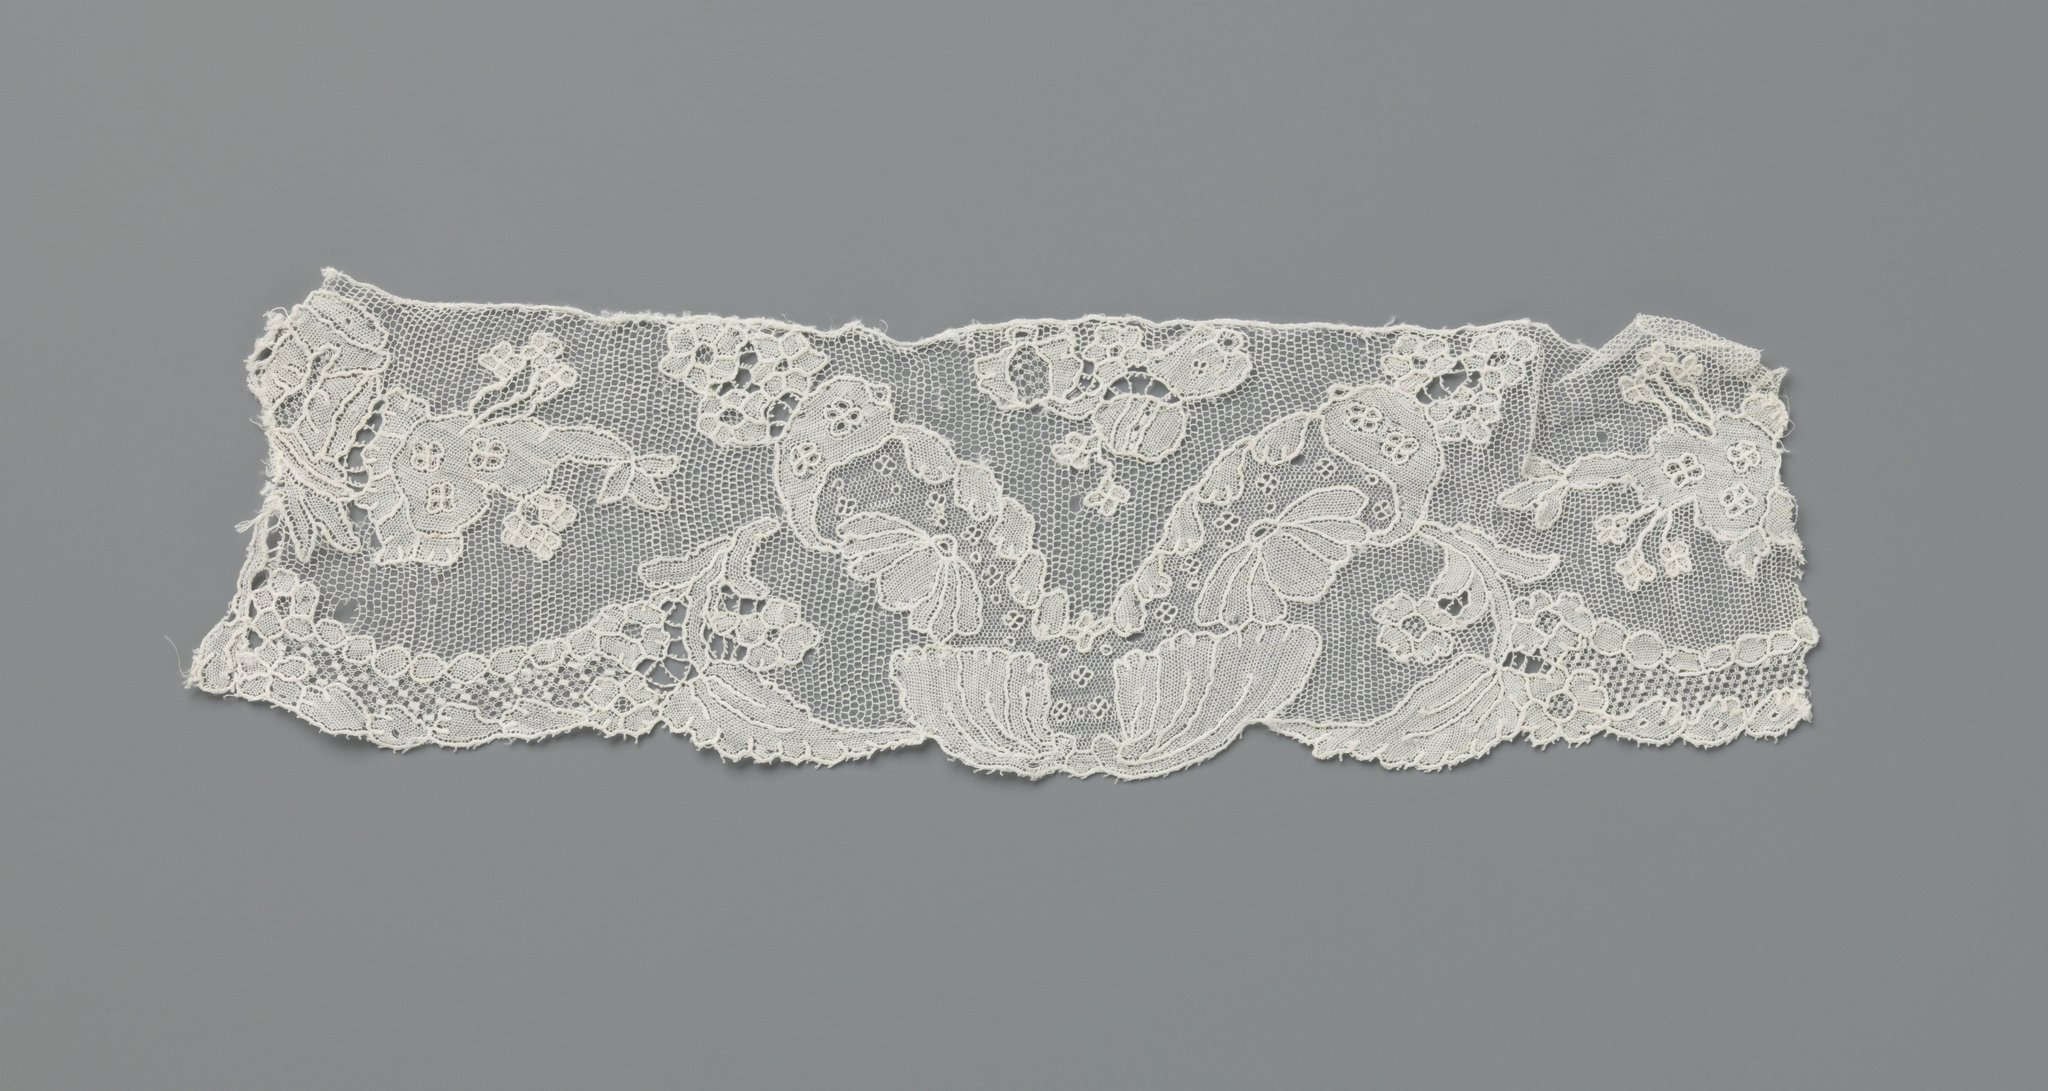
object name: strip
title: Strook kant met v-vormig motief boven opgeklapte schelp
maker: Anonymous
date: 1700-1899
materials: cotton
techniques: lace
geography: burano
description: Strook naturelkleurige naaldkant: Burano-kant. Het symmetrische patroon bestaat uit een v-vormig motief boven een opengeklapte schelp die langs de onderzijde van de strook ligt. De v wordt gevormd door een rij schuin op elkaar gestapelde blaadjes, met bovenaan elke poot een groter druppelvormig en omkrullend blad. Vanuit dit blad buigt een stengel met daaraan drie rozetbloempjes naar beneden. De stengel eindigt met een blad dat langs de onderzijde van de strook ligt en waarvan de top de schelp raakt. In het v-vormige veld hangt bovenin een a-symmetrisch motiefje met een rozetbloempje tussen drie min of meer ovale bloemen of vormen. De motieven zijn met elkaar verbonden door een maasgrond, een Burano-grond. Er zijn verschillende siergronden gebruikt. Onder andere tussen rozetbloempjes en in de sierbanden langs de onderzijde van de strook. De bovenzijde van de strook is recht afgewerkt. De flauwe schulpenrand langs de onderzijde van de strook komt voort uit het patroon.